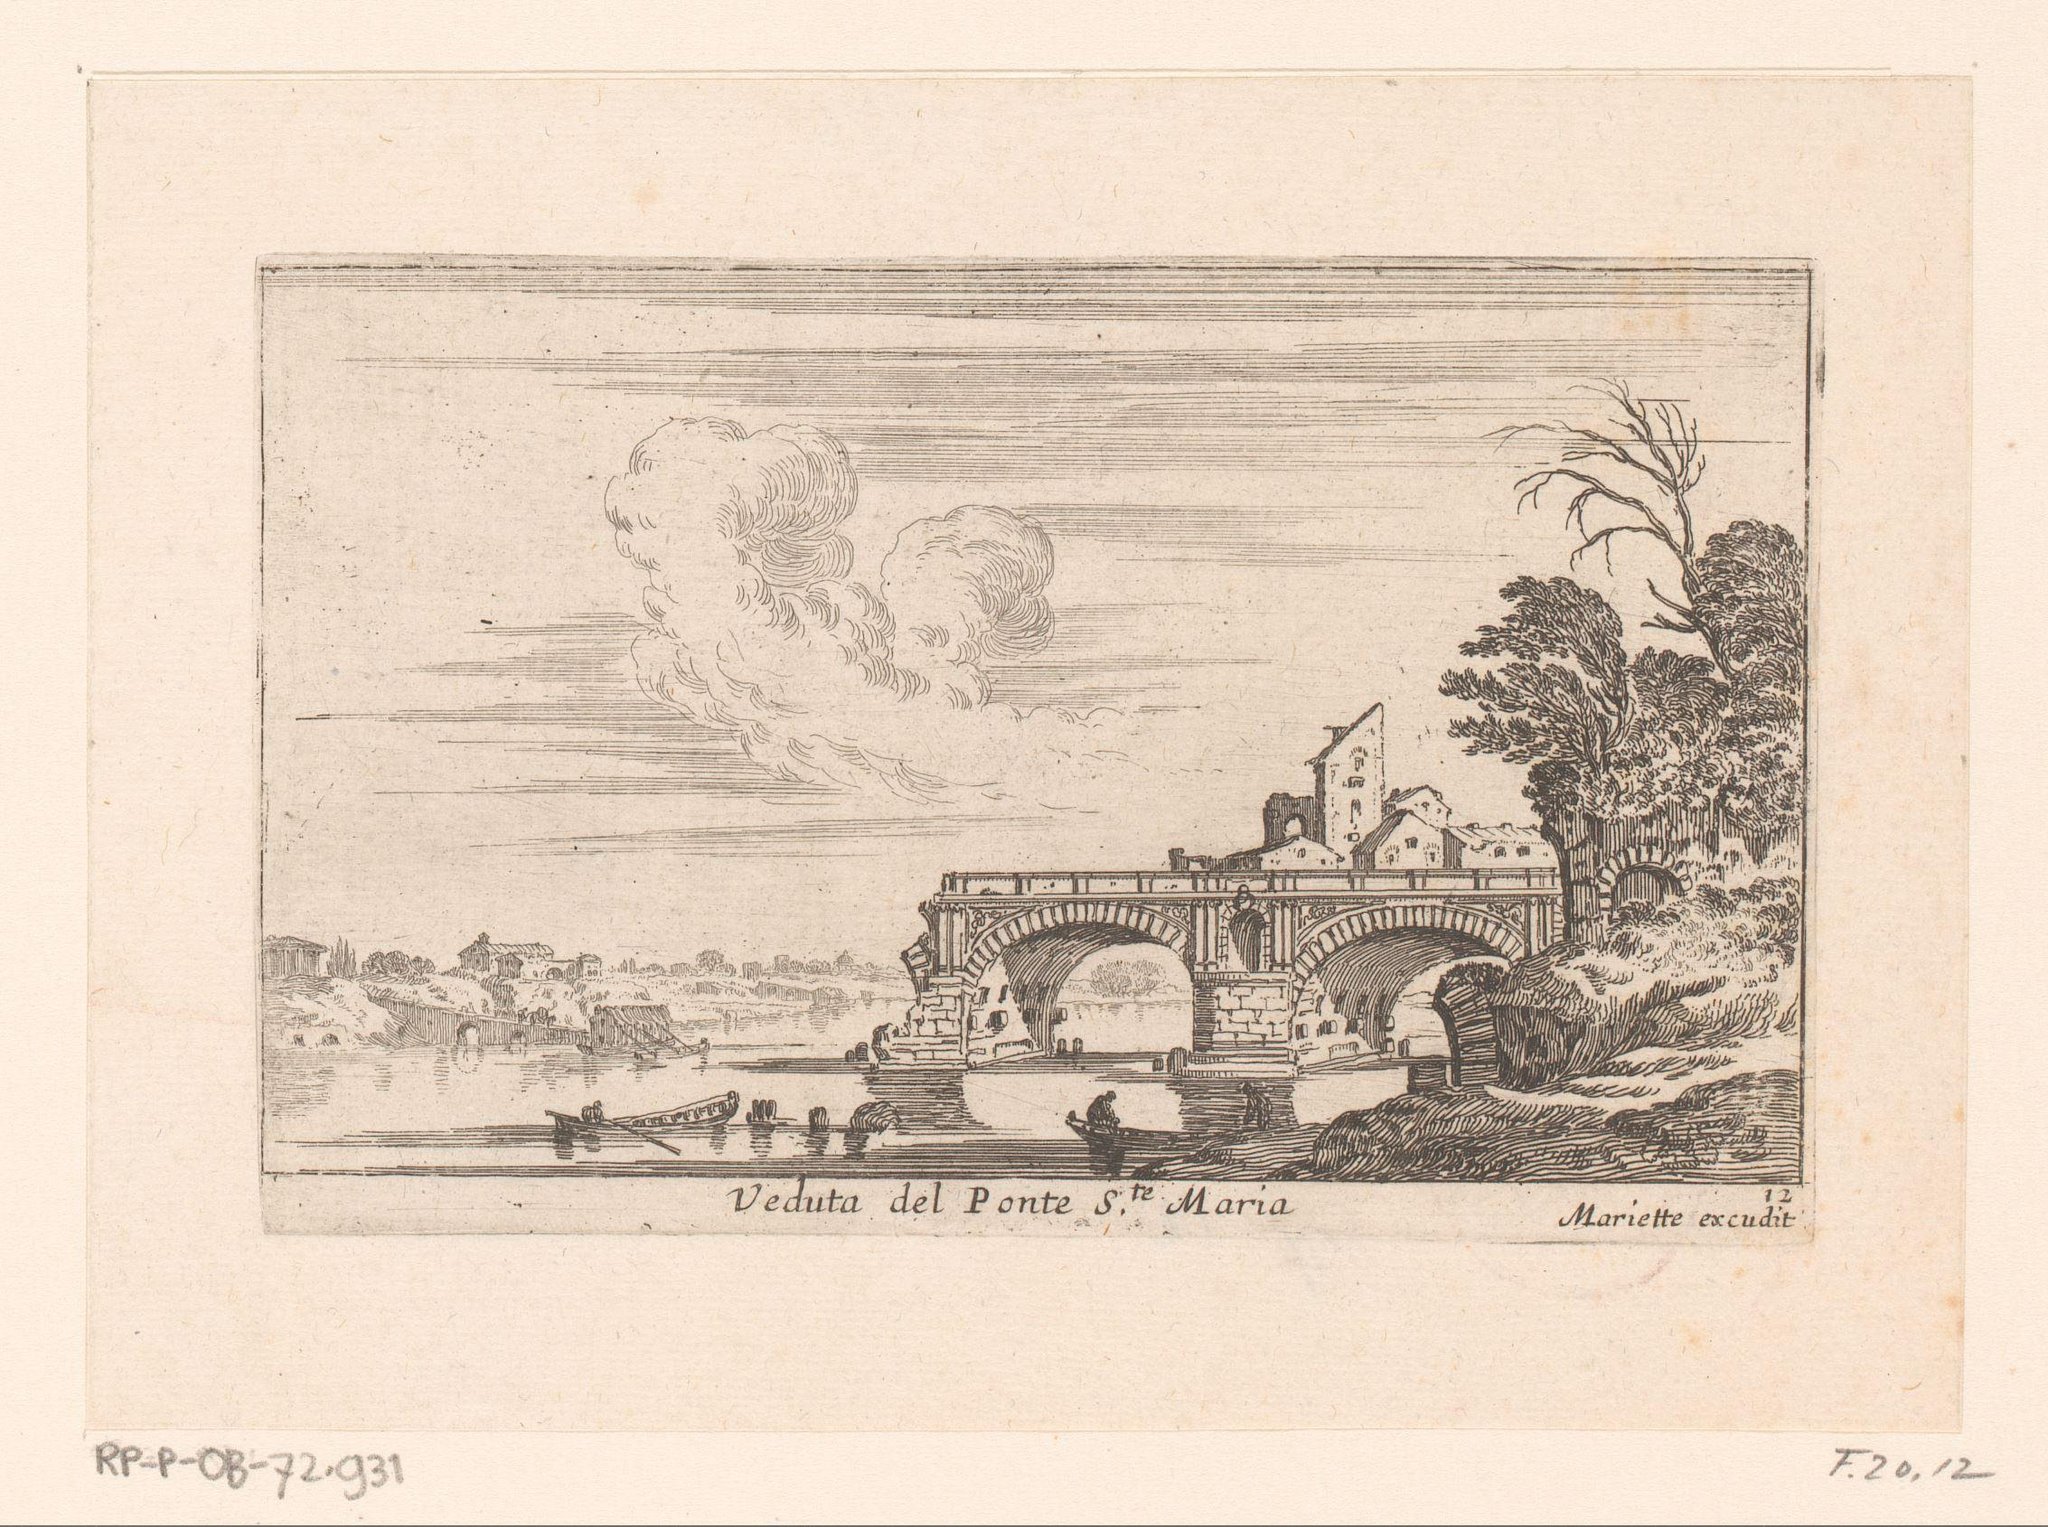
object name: print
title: Veduta del Ponte Ste. Maria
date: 1631-1657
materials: paper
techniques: etching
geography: france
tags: landscape with bridge, viaduct or aqueduct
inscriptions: collector's mark: Lugt 240